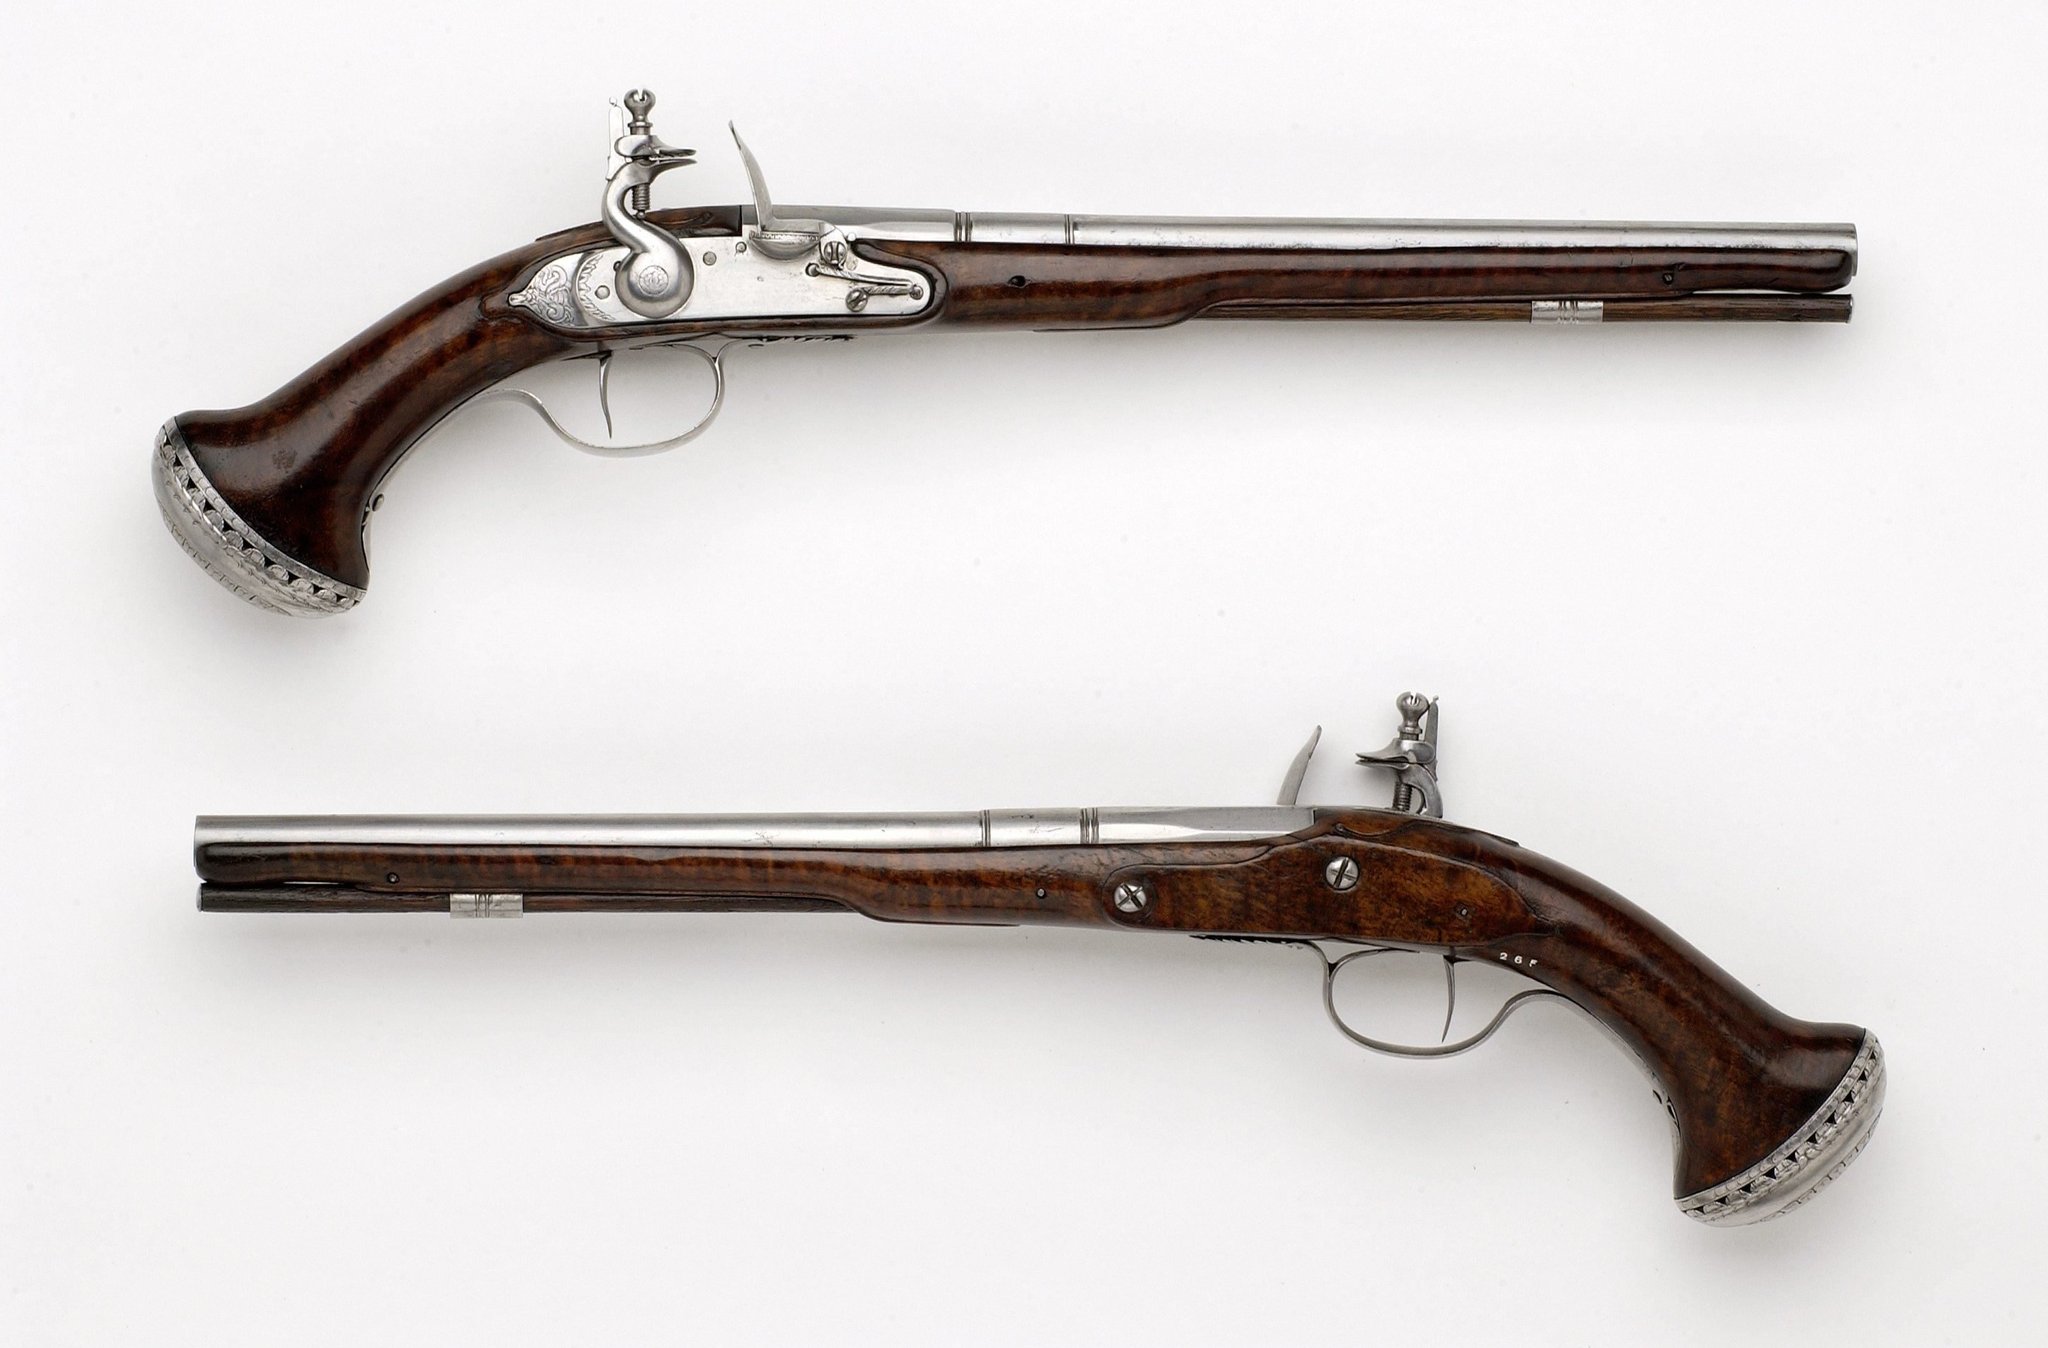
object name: flintlock pistol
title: Vuursteenpistool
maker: Anonymous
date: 1655-1660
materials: iron, wood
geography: netherlands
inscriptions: mark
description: Niet gemerkt, doch zeer Hollands van vorm en uitvoering. Op de slotplaat staat een draak gegraveerd met lofwerk. De loop is voorzien van twee ringen en onderop gestempeld met een niet te identificeren merk. De kolf is eenvoudig gesneden. Het ijzeren beslag bestaat onder meer uit een laadstokkoker en een lusvormige, aan de voorkant gevorkte trekkerbeugel en een bootvormige kolfknop met een ajour bewerkte rand en vogels en lofwerk erop gegraveerd; de laadstok is voorzien van een ijzeren kap.